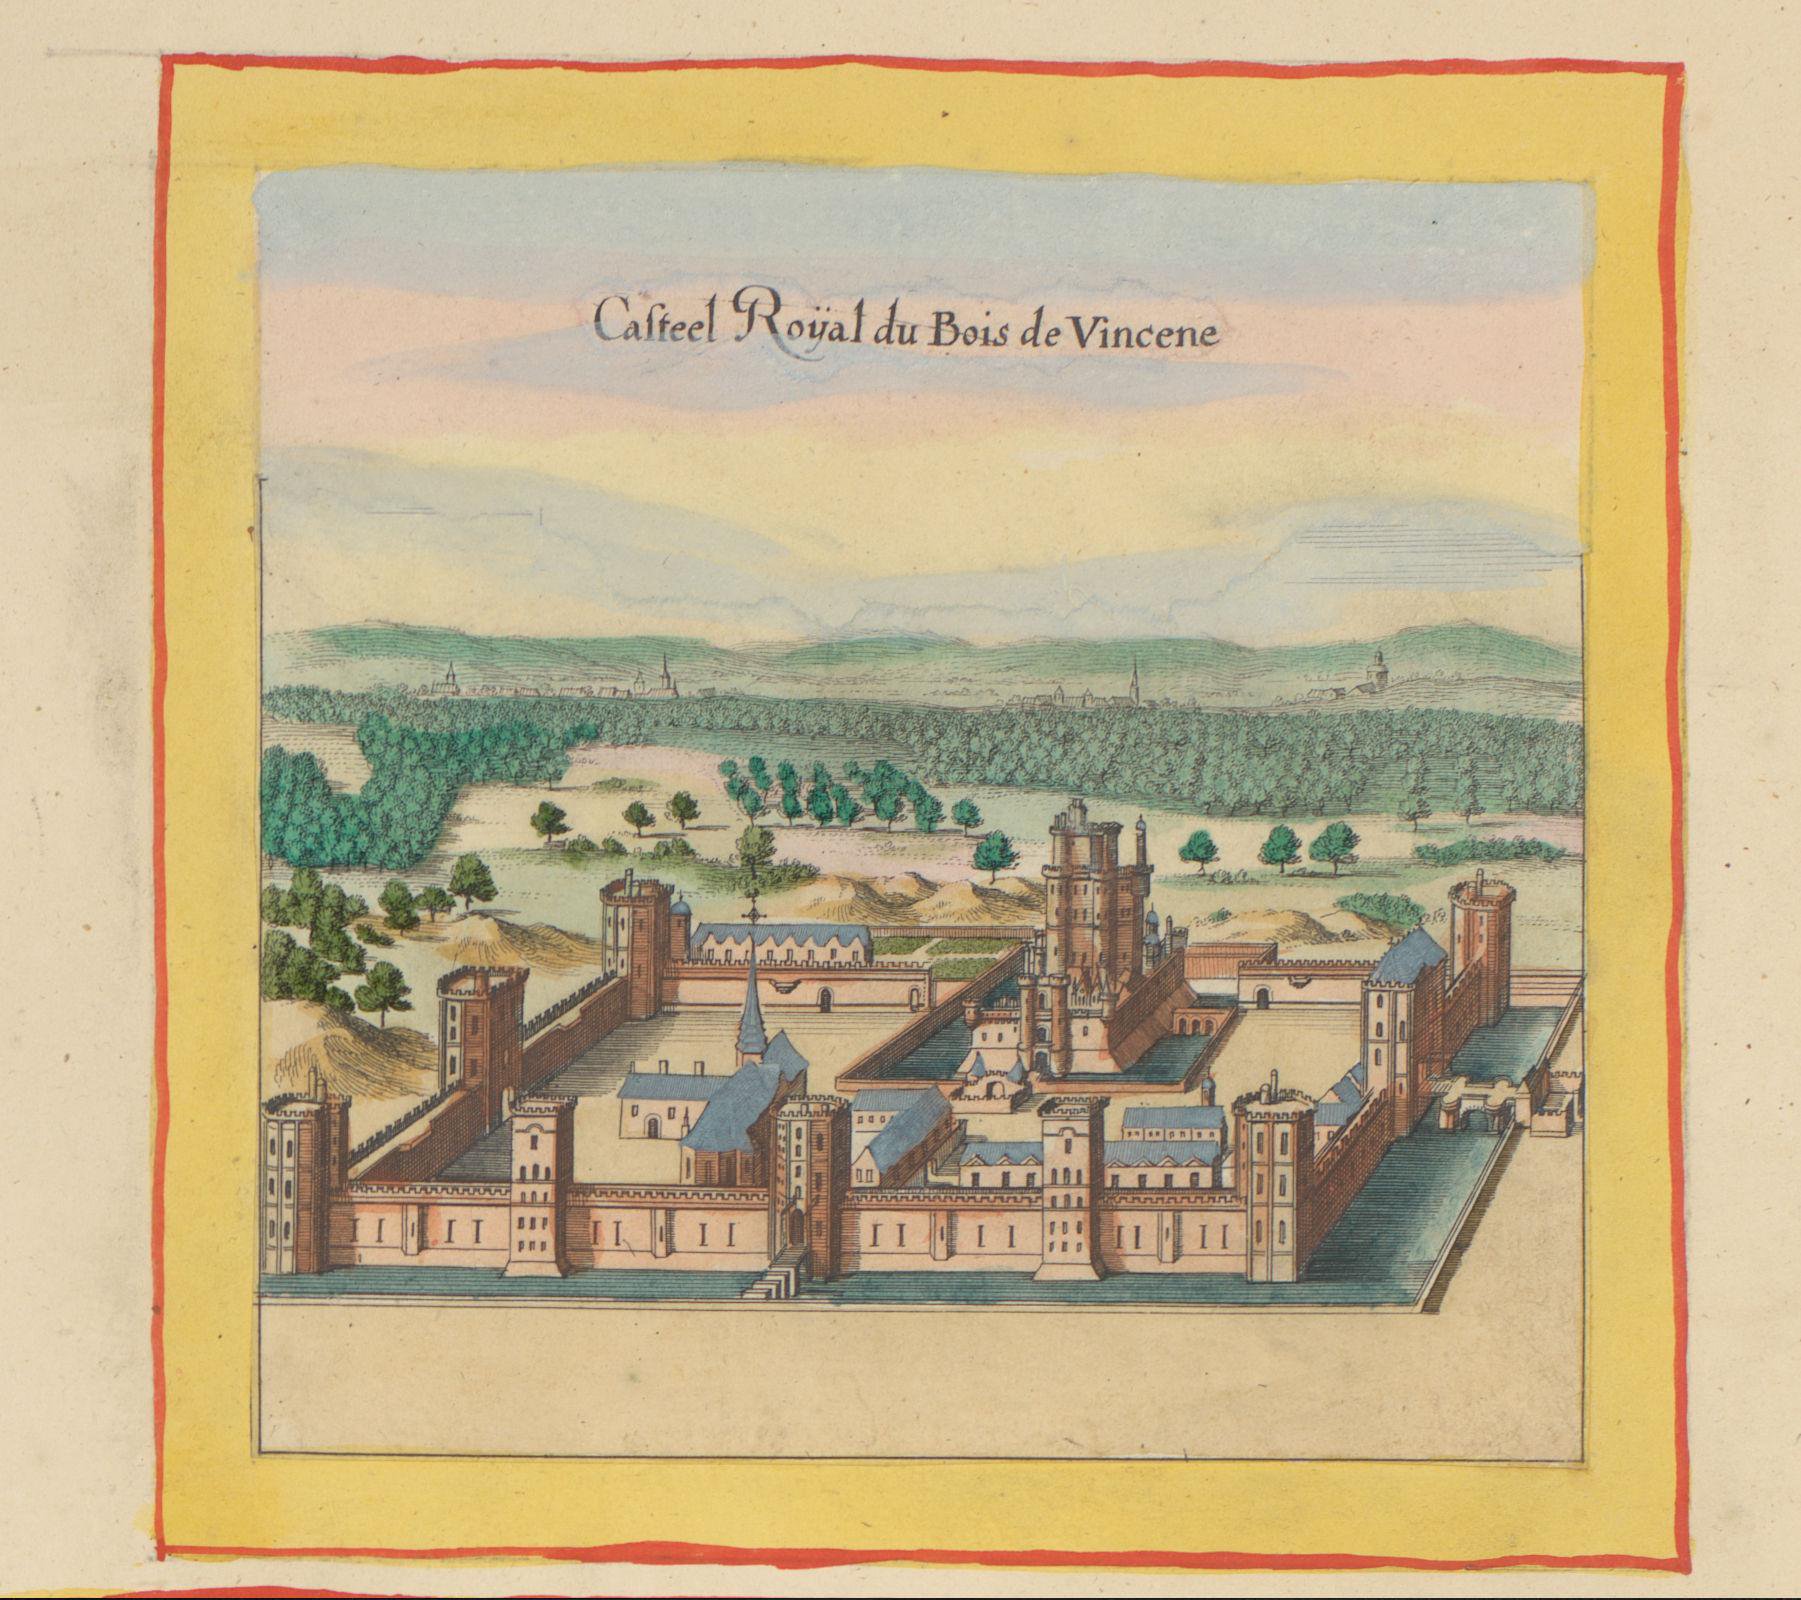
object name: album leaf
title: Casteel Royal du Bois de Vincene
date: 1655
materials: paper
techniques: engraving, etching, hand coloring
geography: paris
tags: castle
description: Prent origineel vervaardigd als boekillustratie voor: Zeiller, Martin. Topographia Galliae, oder Beschreibung und Contrafaitung der vornehmbsten und bekantisten Oerter in dem mächtigen und grossen Königreich Frankreich, 13 delen. Frankfurt am Main: Caspar Merian, 1655-1661. De prent werd voor het eerst gepubliceerd in deel 1: Topographia Galliae, 1655. De prent is langs de bovenrand van de voorstelling afgescheurd. De voorstelling is aan de bovenzijde aangevuld met een geschilderde lucht.